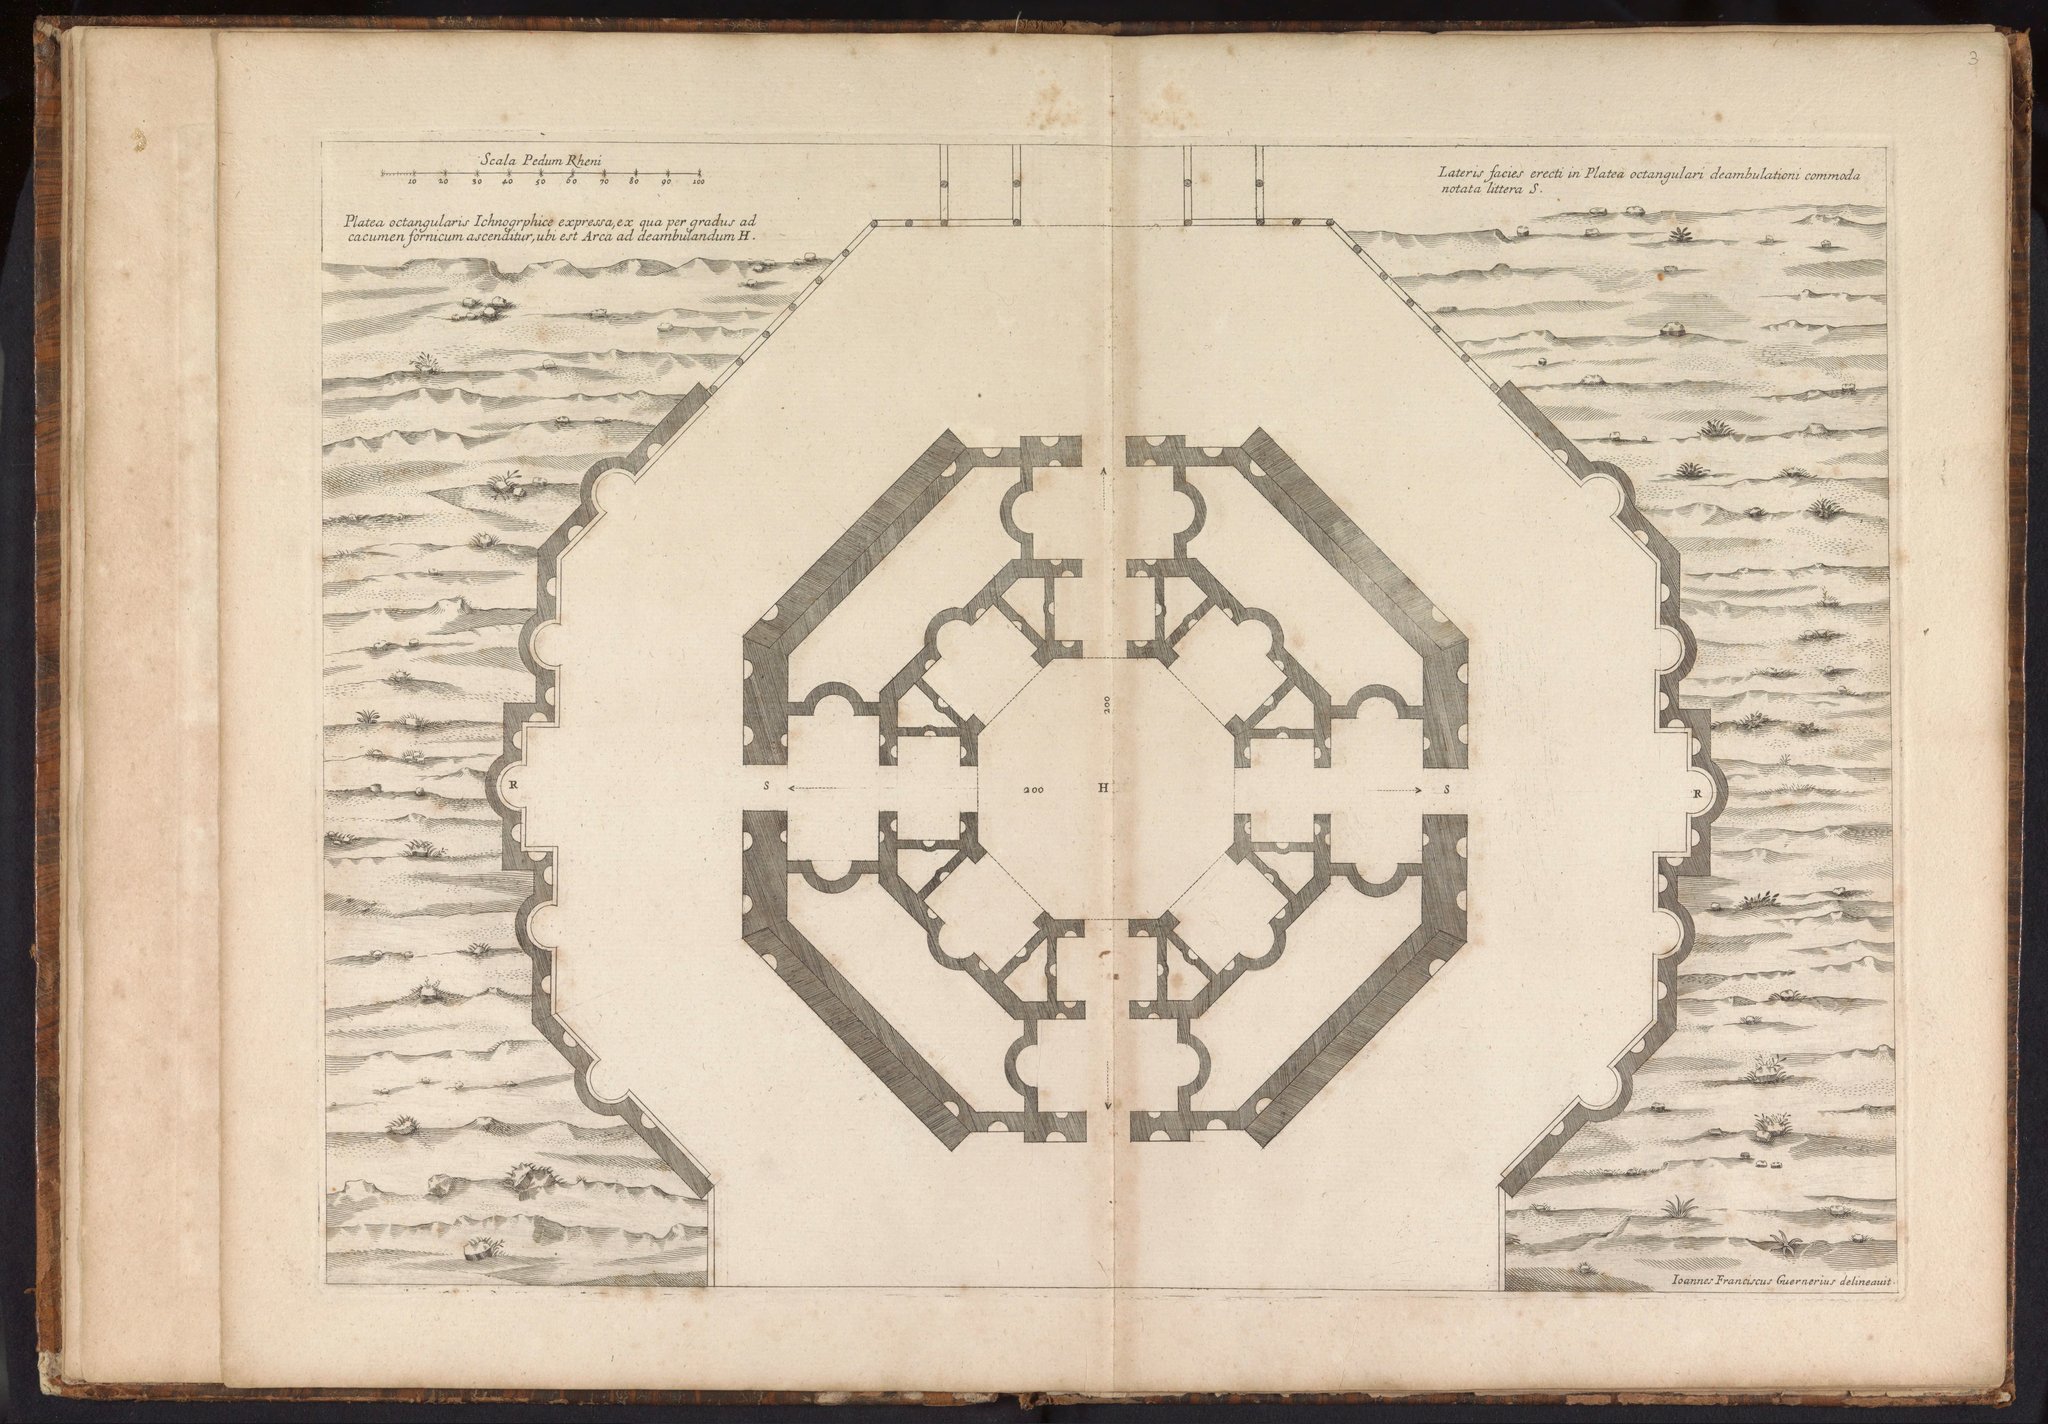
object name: print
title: Platea octangularis ichnogrphice expressa, ex qua per gradus ad cacumen fornicum ascenditur (...)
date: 1706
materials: paper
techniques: etching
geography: italy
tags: palace, plan ~ architecture